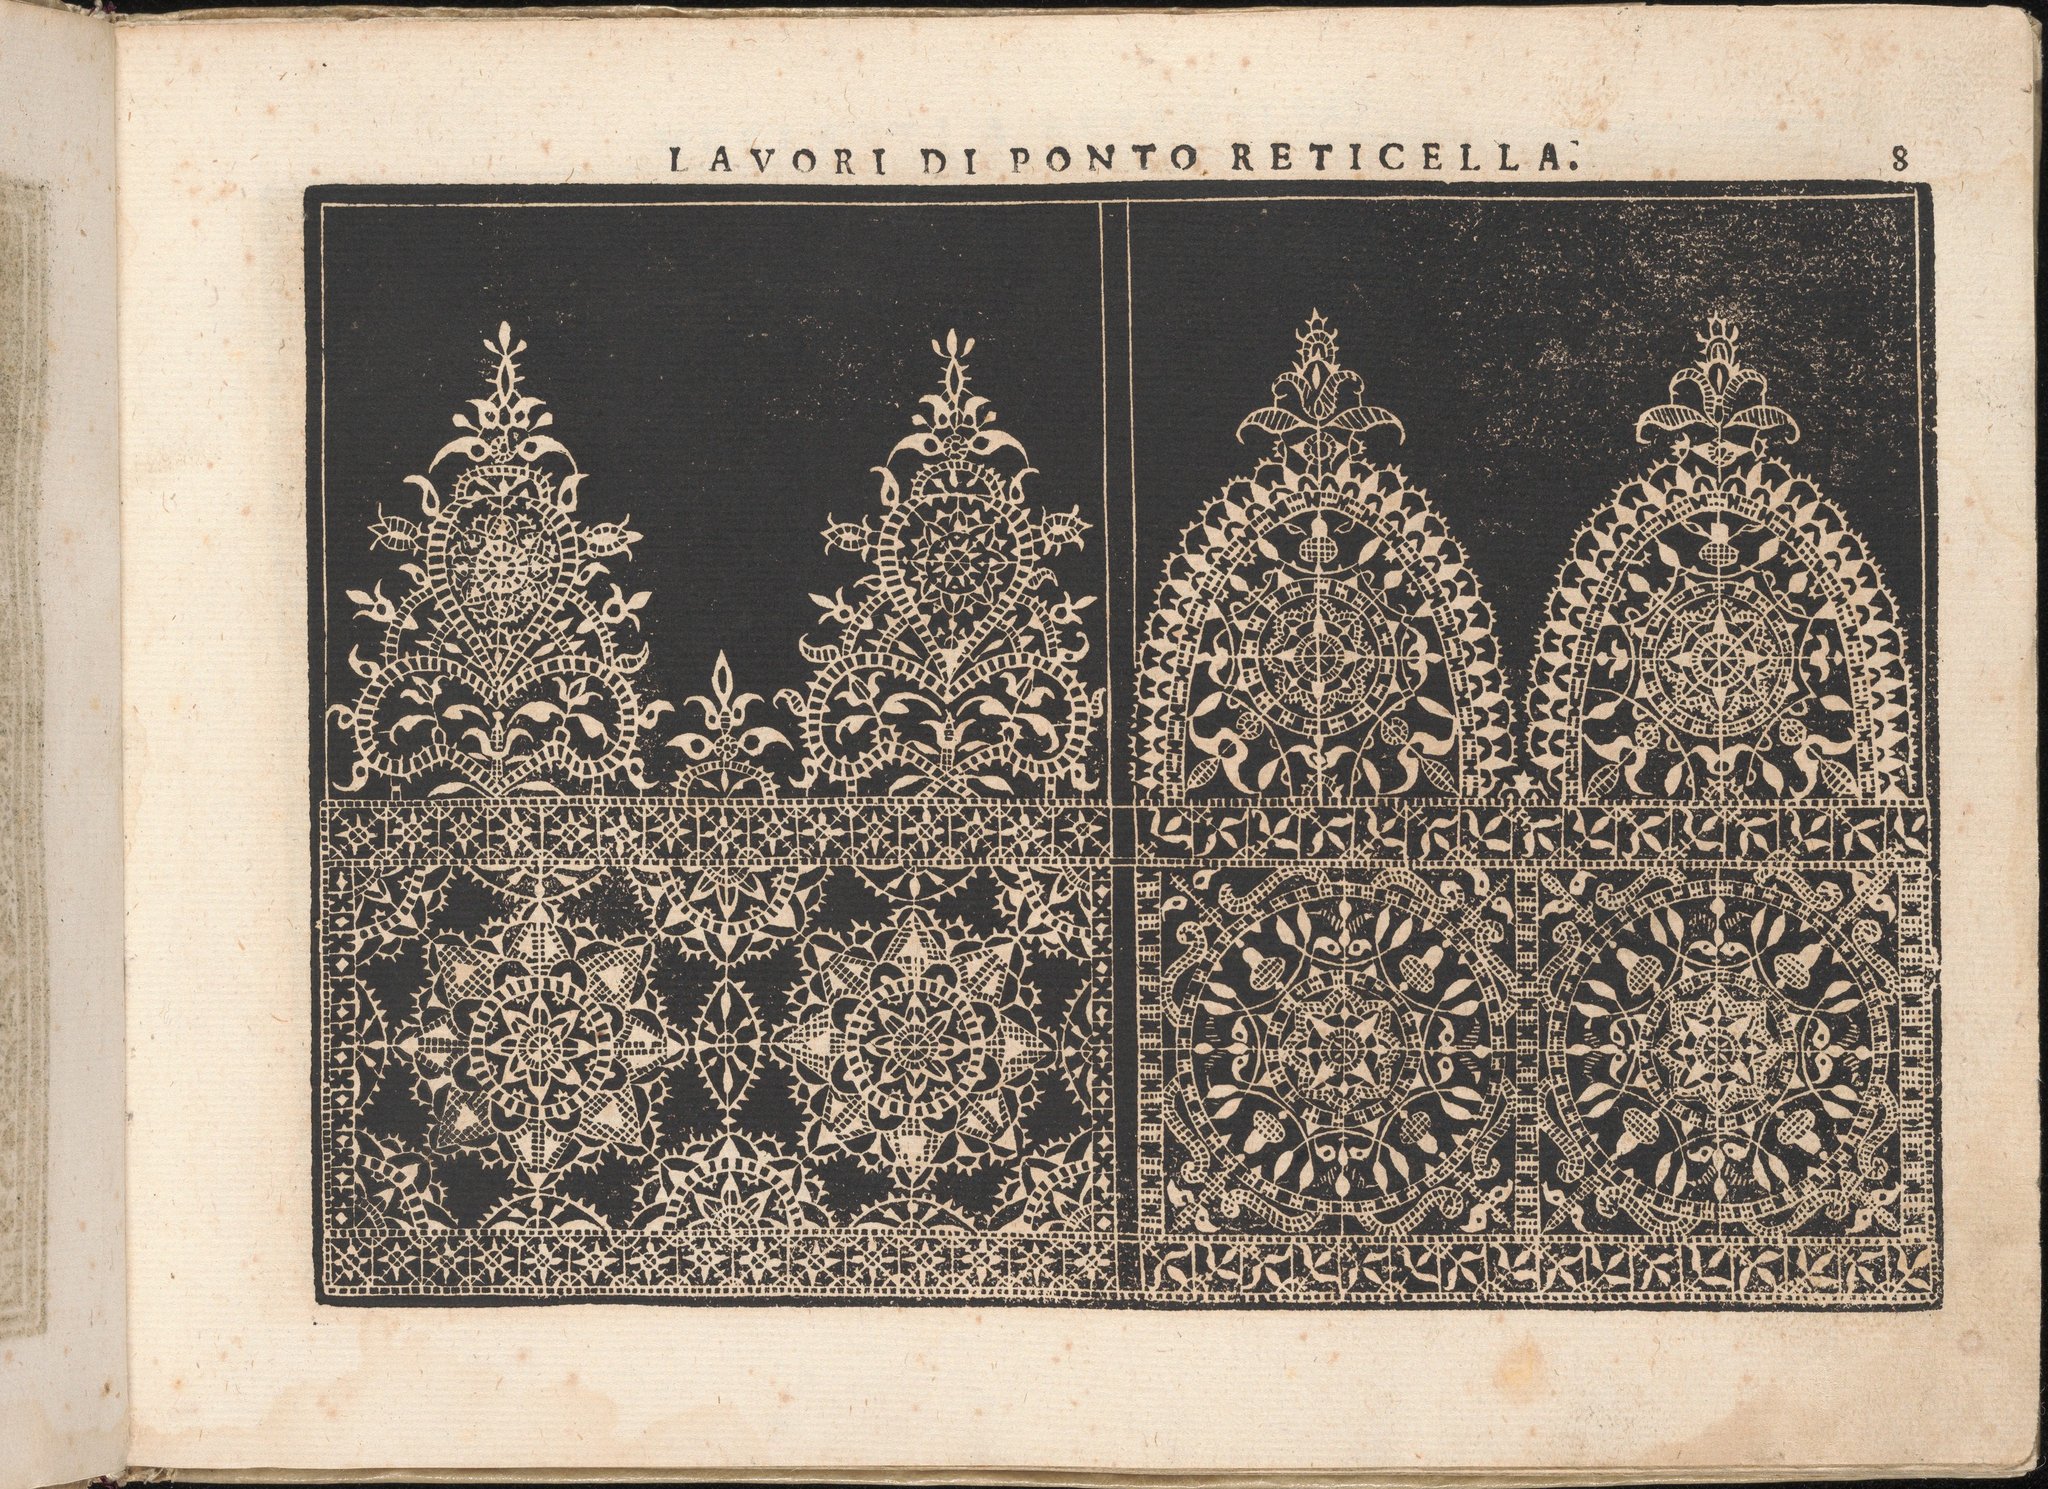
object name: book print ornament architecture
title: Fiore D'Ogni Virtu Per le Nobili Et Honeste Matrone, page 8 (recto)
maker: isabella catanea parasole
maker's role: designer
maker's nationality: italian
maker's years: 1565-1625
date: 1610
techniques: woodcut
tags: flowers,vines